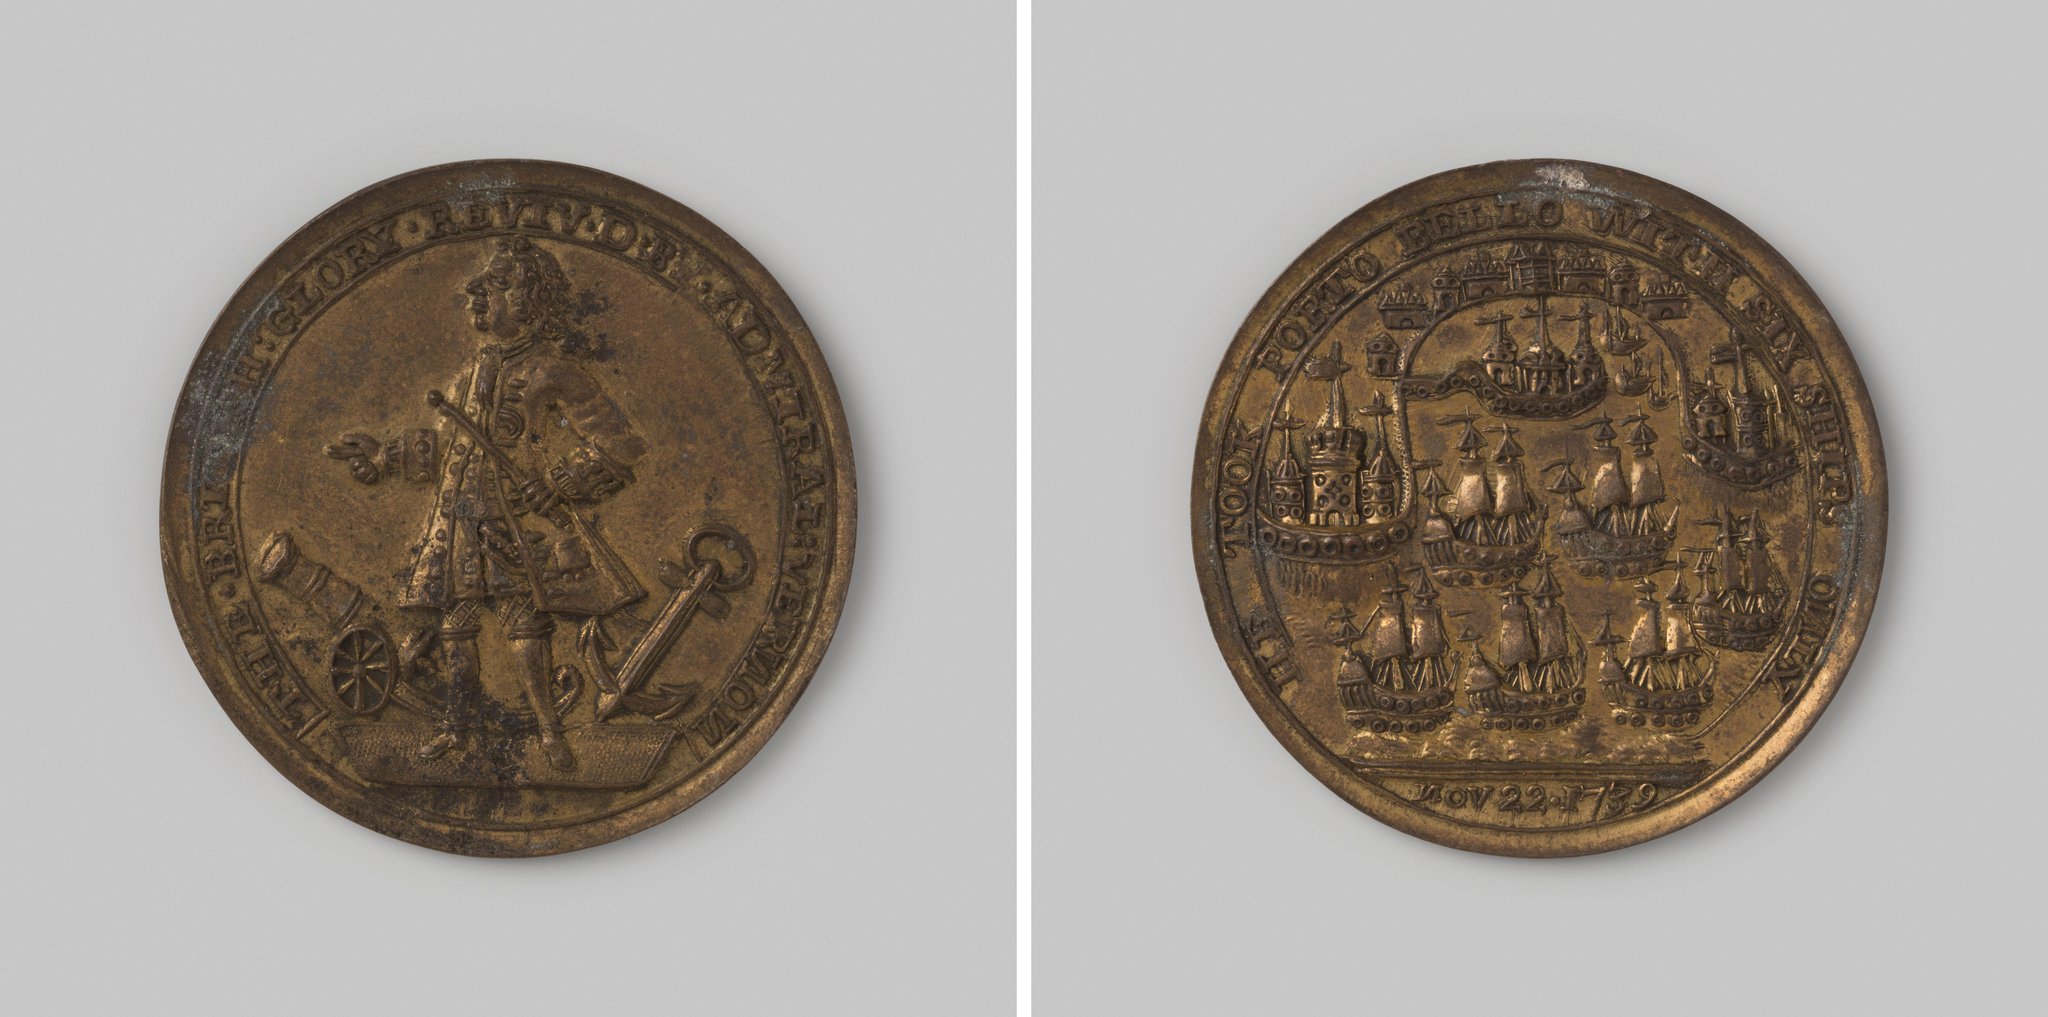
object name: history medal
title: Inname van Porto-Bello door Admiraal Vernon 1739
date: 1739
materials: brass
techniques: striking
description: Verguld messing penning, op de voorzijde Vernon staand naar links met zwaard, een kanon en een anker aan zijn voeten, met omschrift, op de keerzijde de haven van Porto Bello waarvoor zes schepen, met omschrift en afsnedetekst.